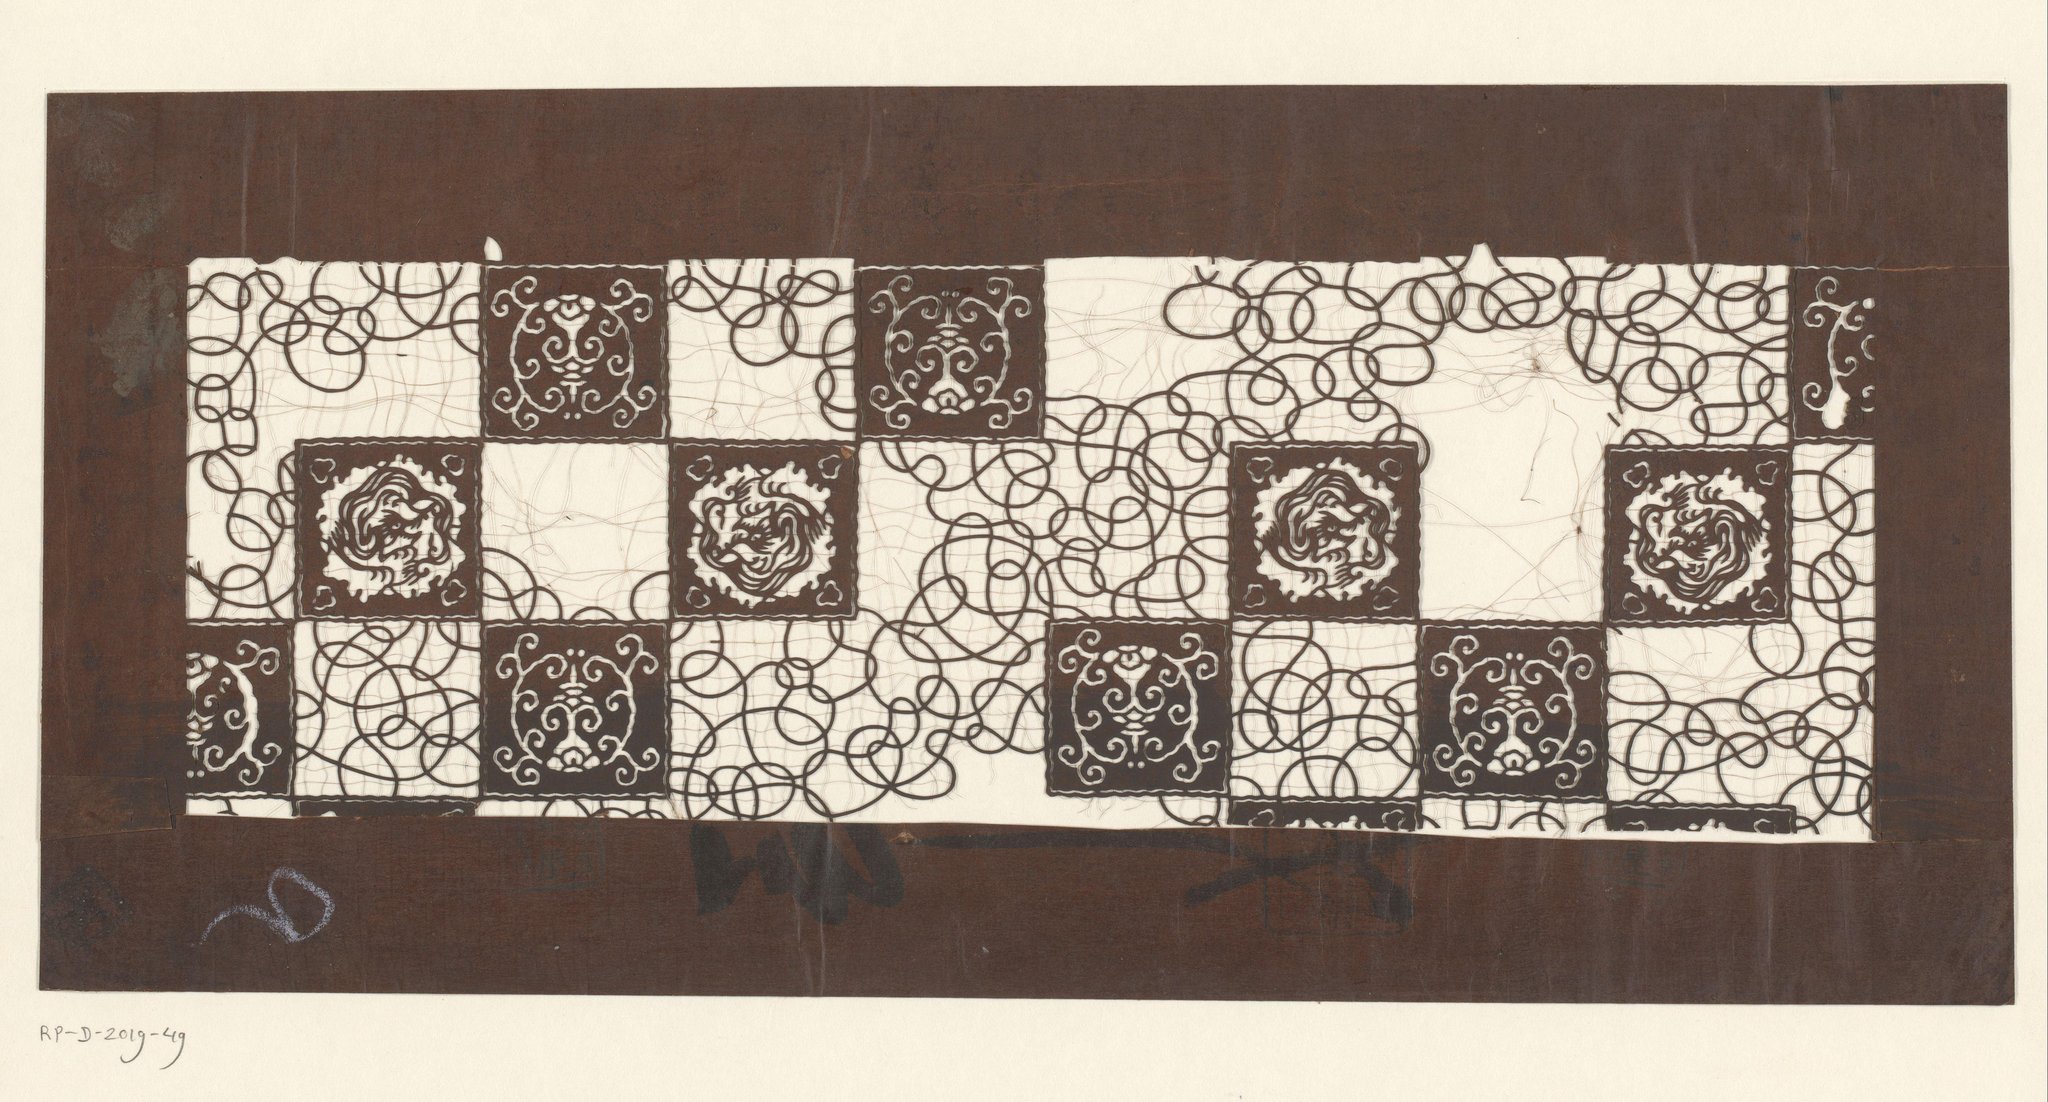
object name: katagami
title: Sjabloon met vierkanten met draken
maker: Anonymous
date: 1800-1909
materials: paper, silk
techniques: cutting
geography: japan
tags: ornament derived from animal forms, dragon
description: Japanse sjabloon (katagami) met een patroon van afwisselende vierkanten met draakmotief en ornament, tussen de blokken slingerende lijnen. Op het gebruikte papier zijn Japanse tekst en stempels zichtbaar.